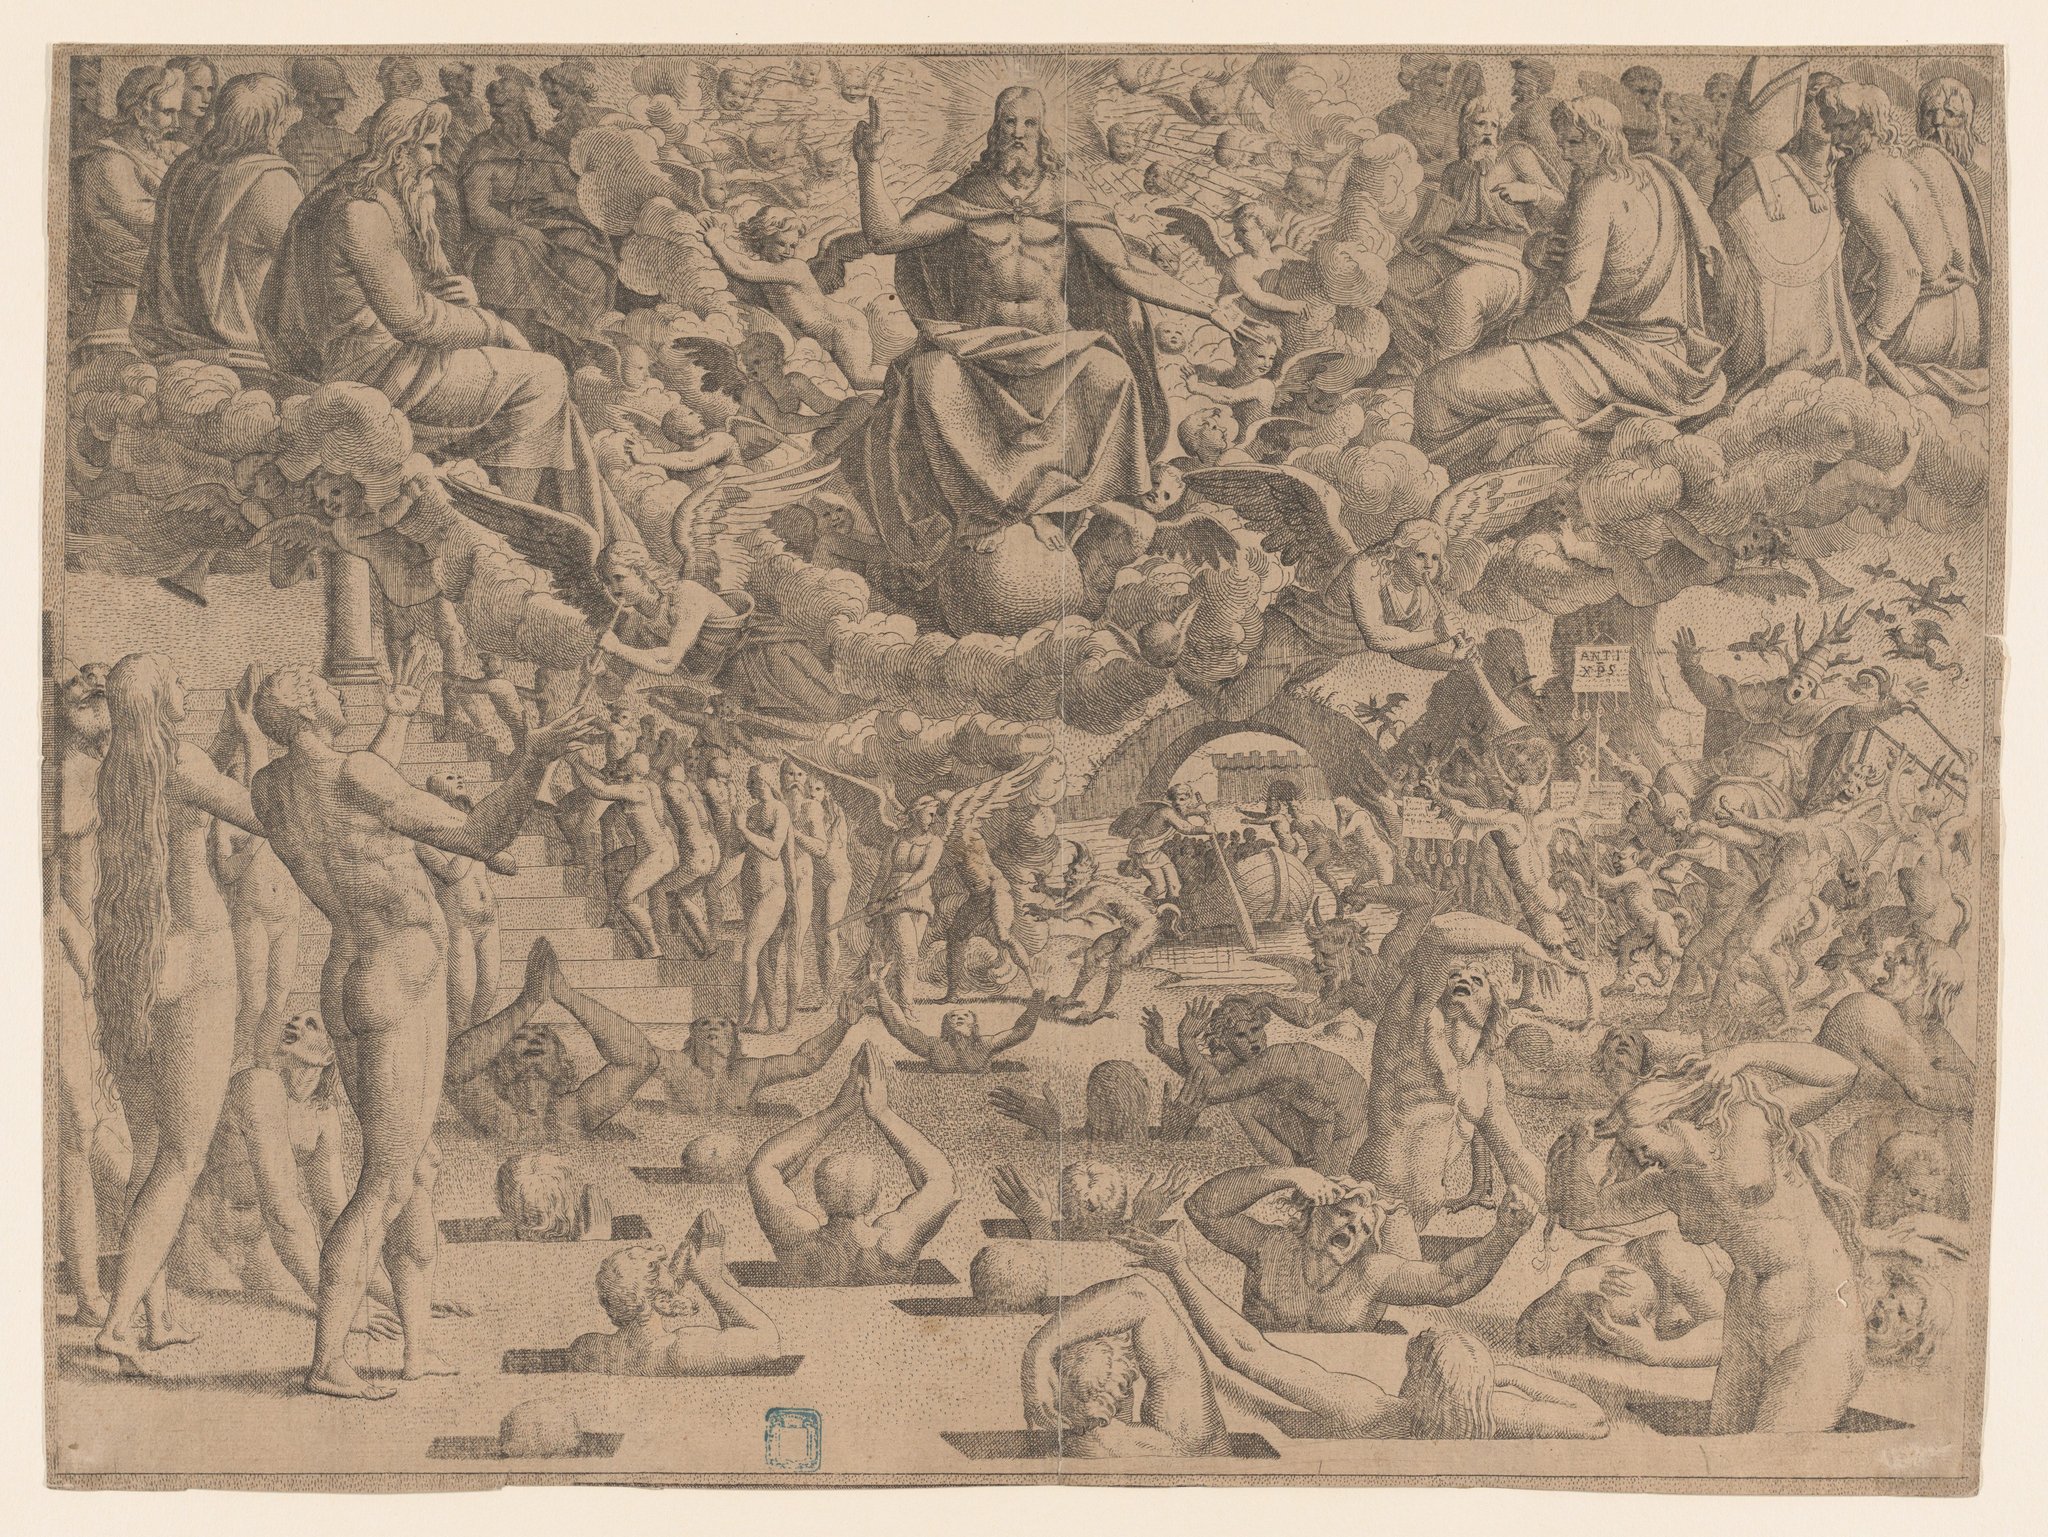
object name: print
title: The Last Judgment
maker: jean mignon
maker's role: artist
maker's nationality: french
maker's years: 1535-1555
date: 1535-1555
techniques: etching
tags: last judgement